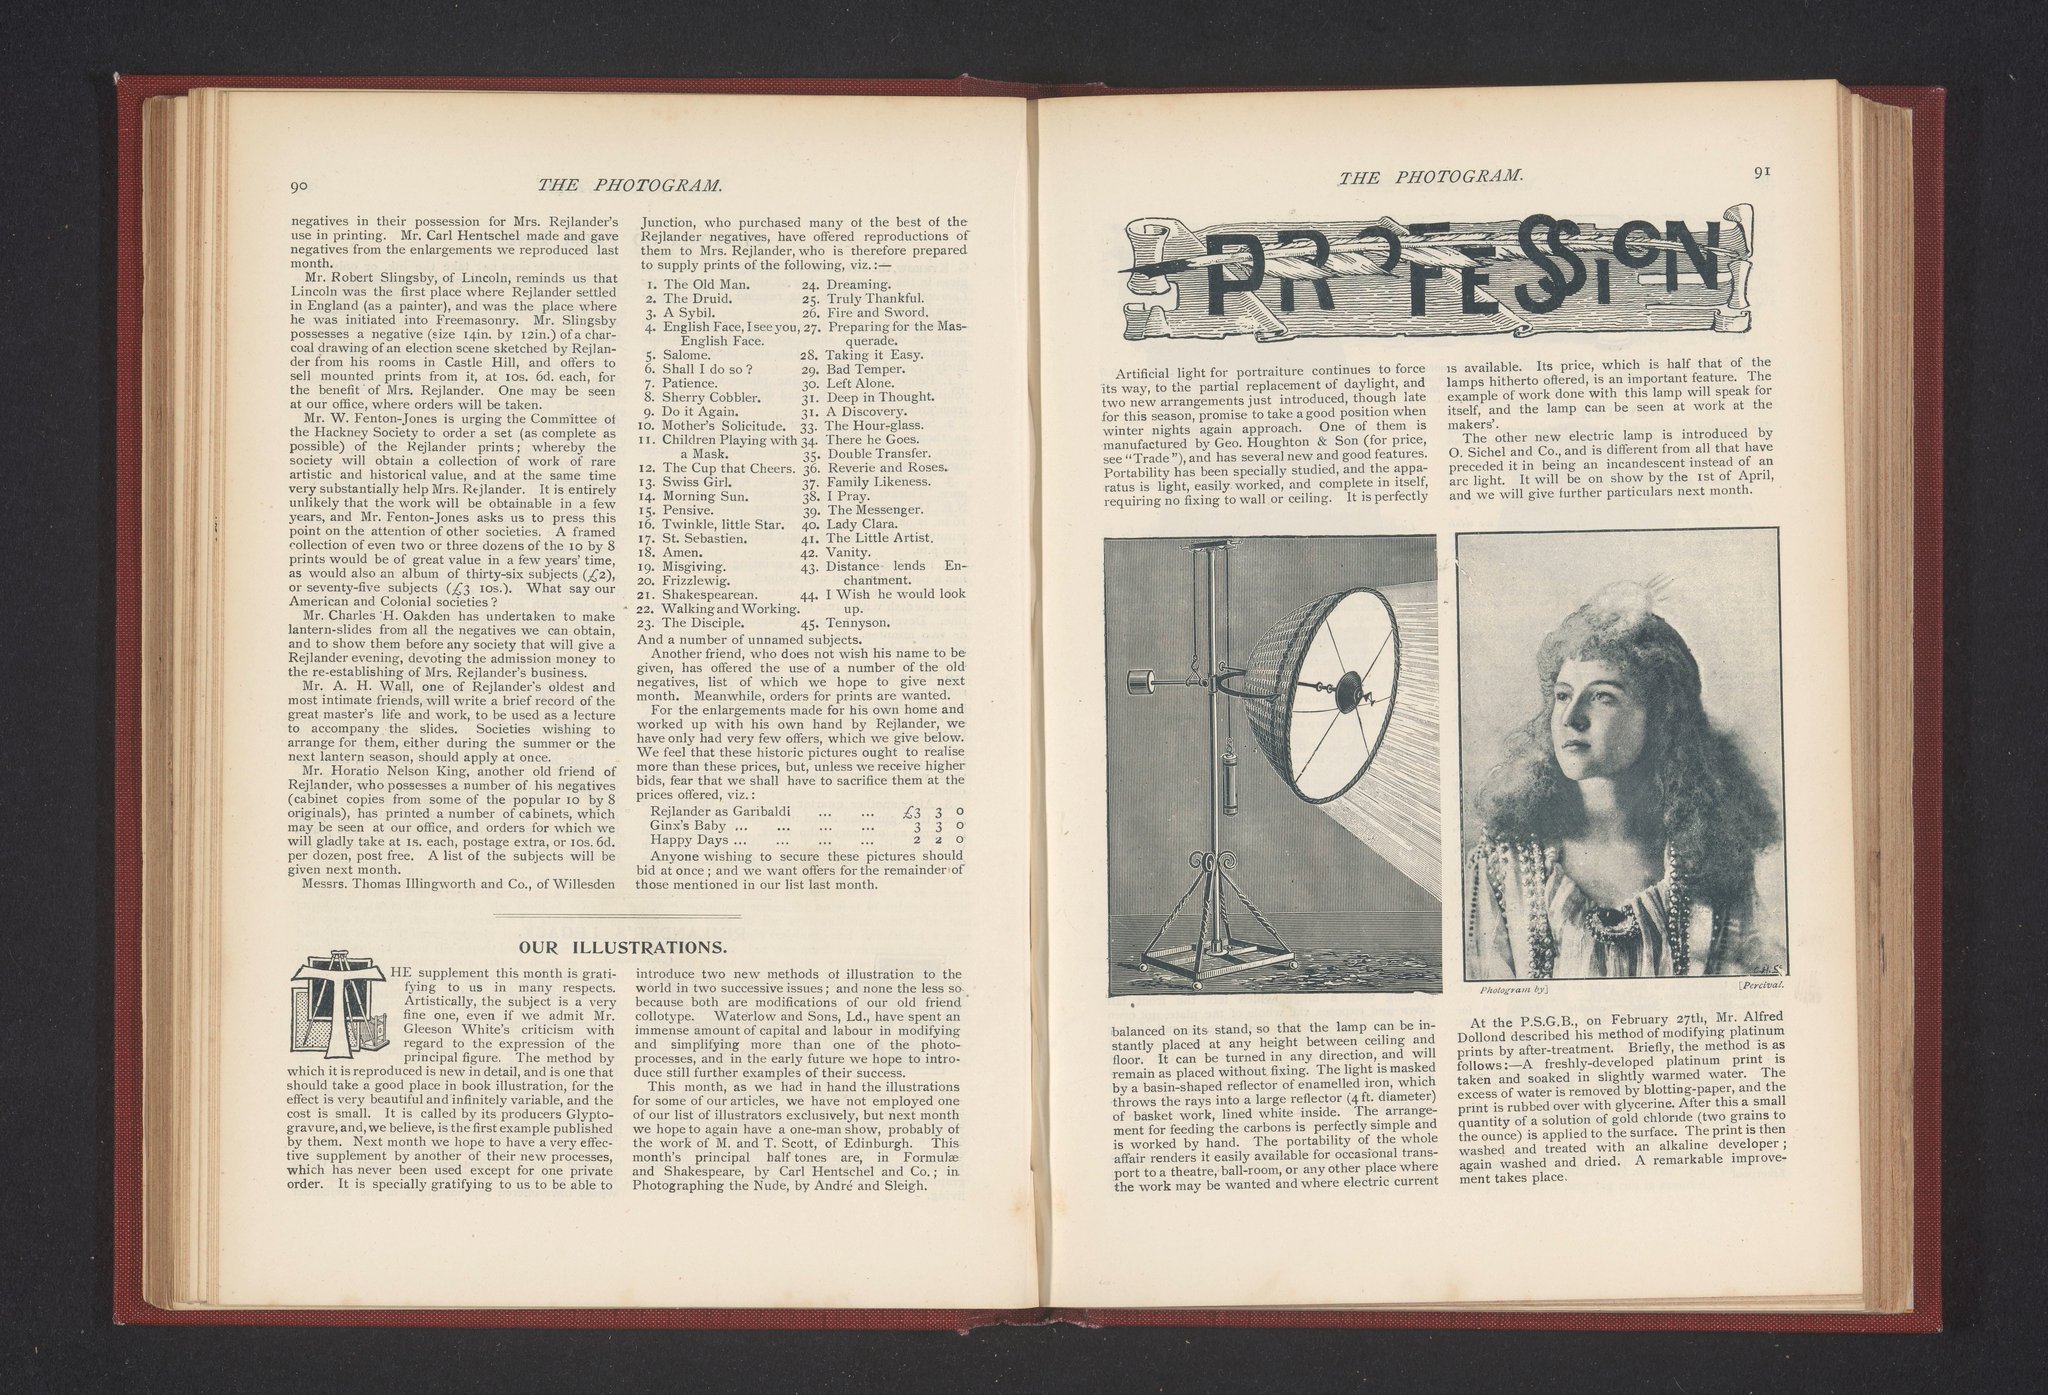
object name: page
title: Portret van een onbekende vrouw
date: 1889-1894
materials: paper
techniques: autotype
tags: historical persons - bb - woman